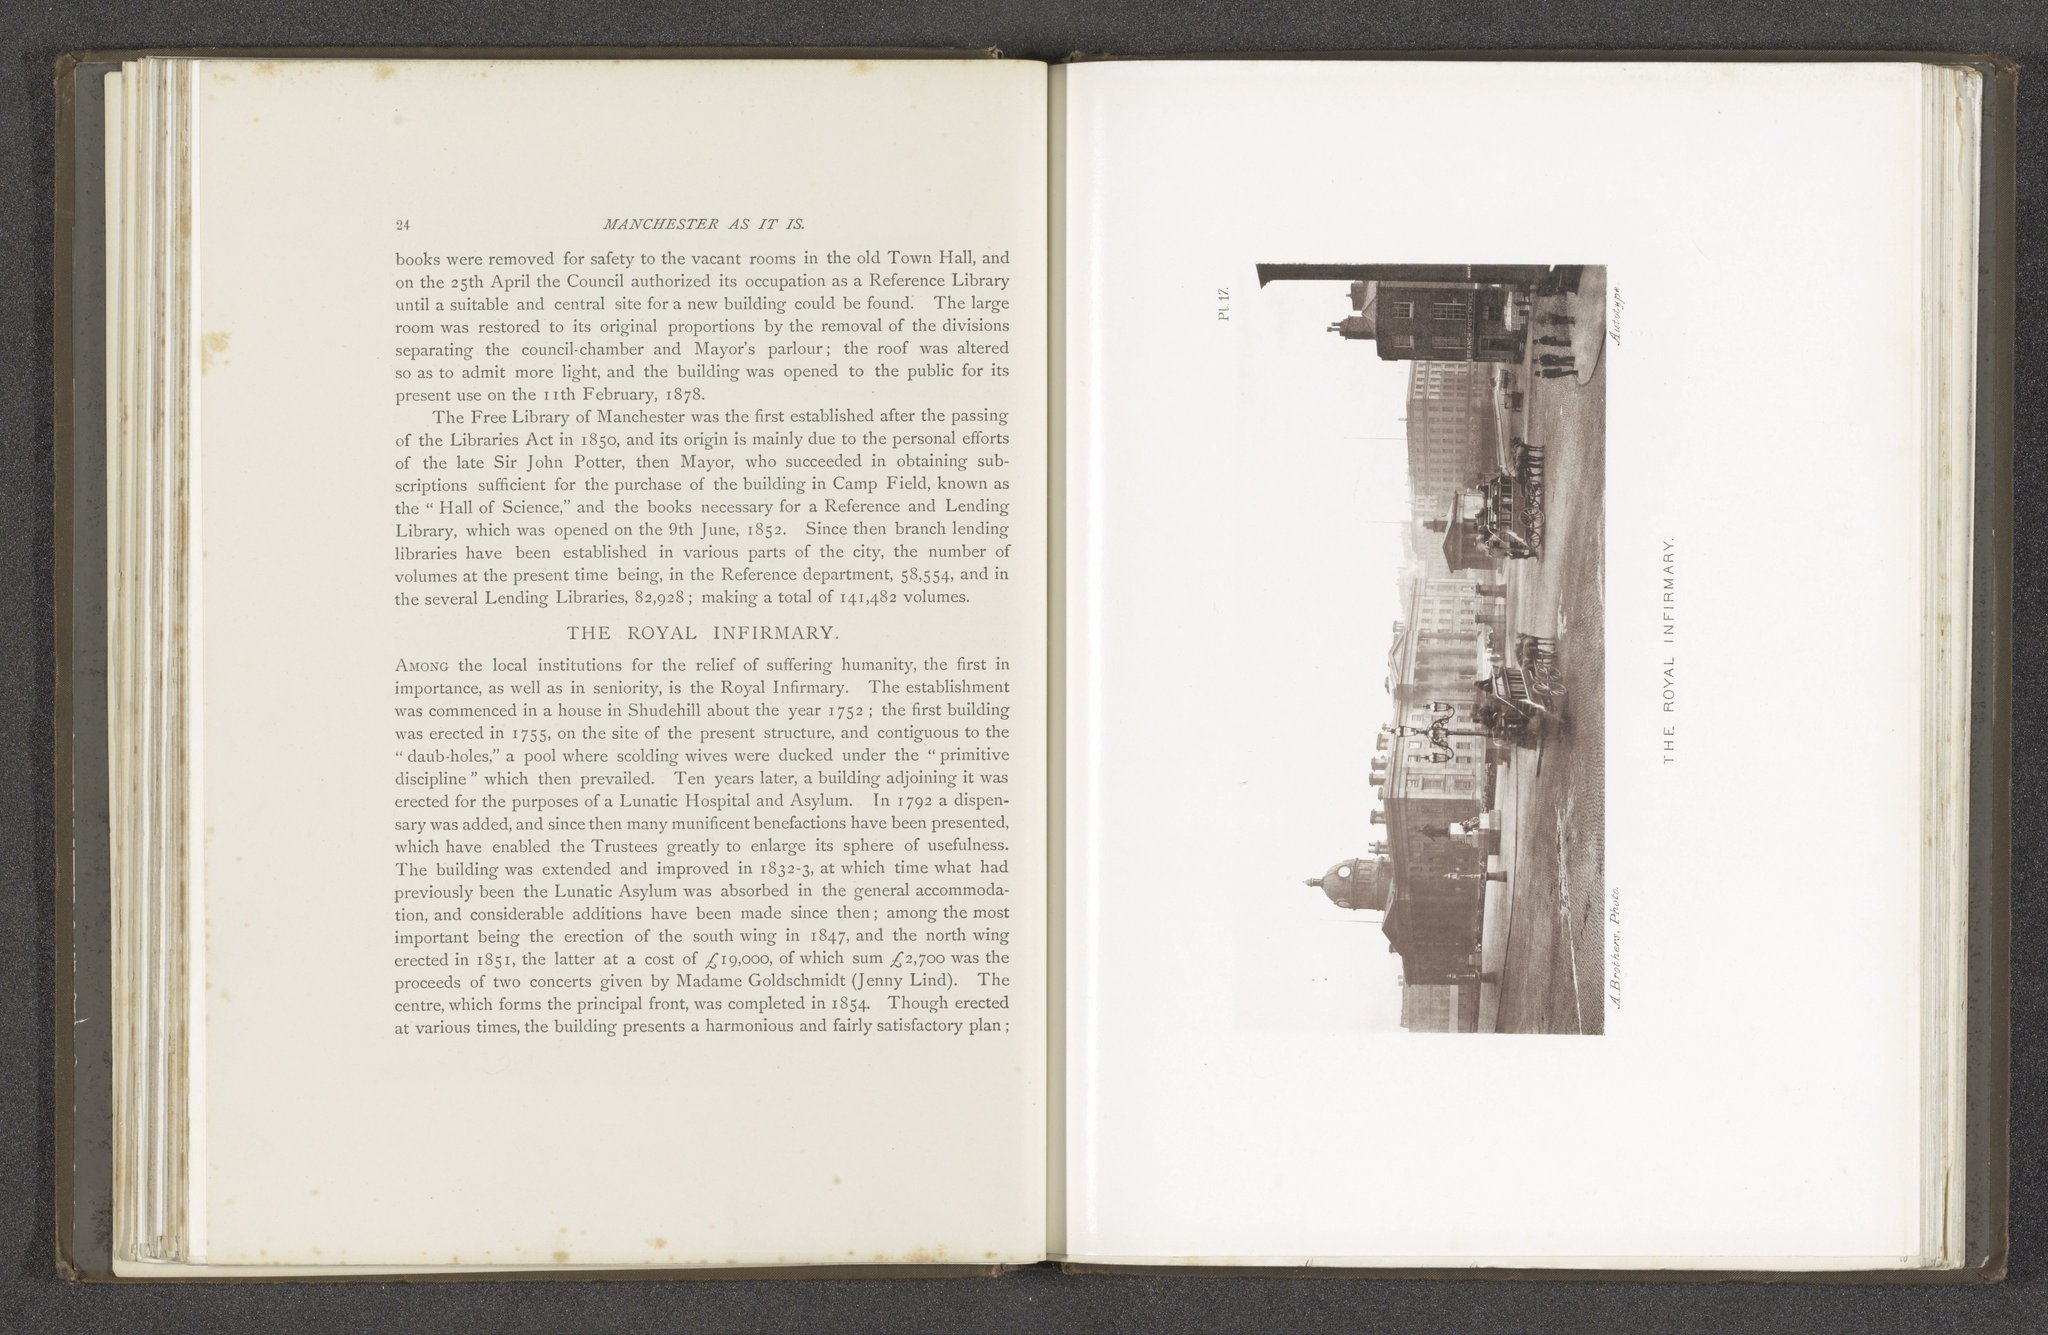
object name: page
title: The Royal Infirmary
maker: Anonymous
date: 1868-1878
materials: paper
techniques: photograph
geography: manchester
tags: four-wheeled, animal-drawn vehicle, e.g.: cab, carriage, coach, hospital, manchester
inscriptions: number: ‘Pl. 17.’